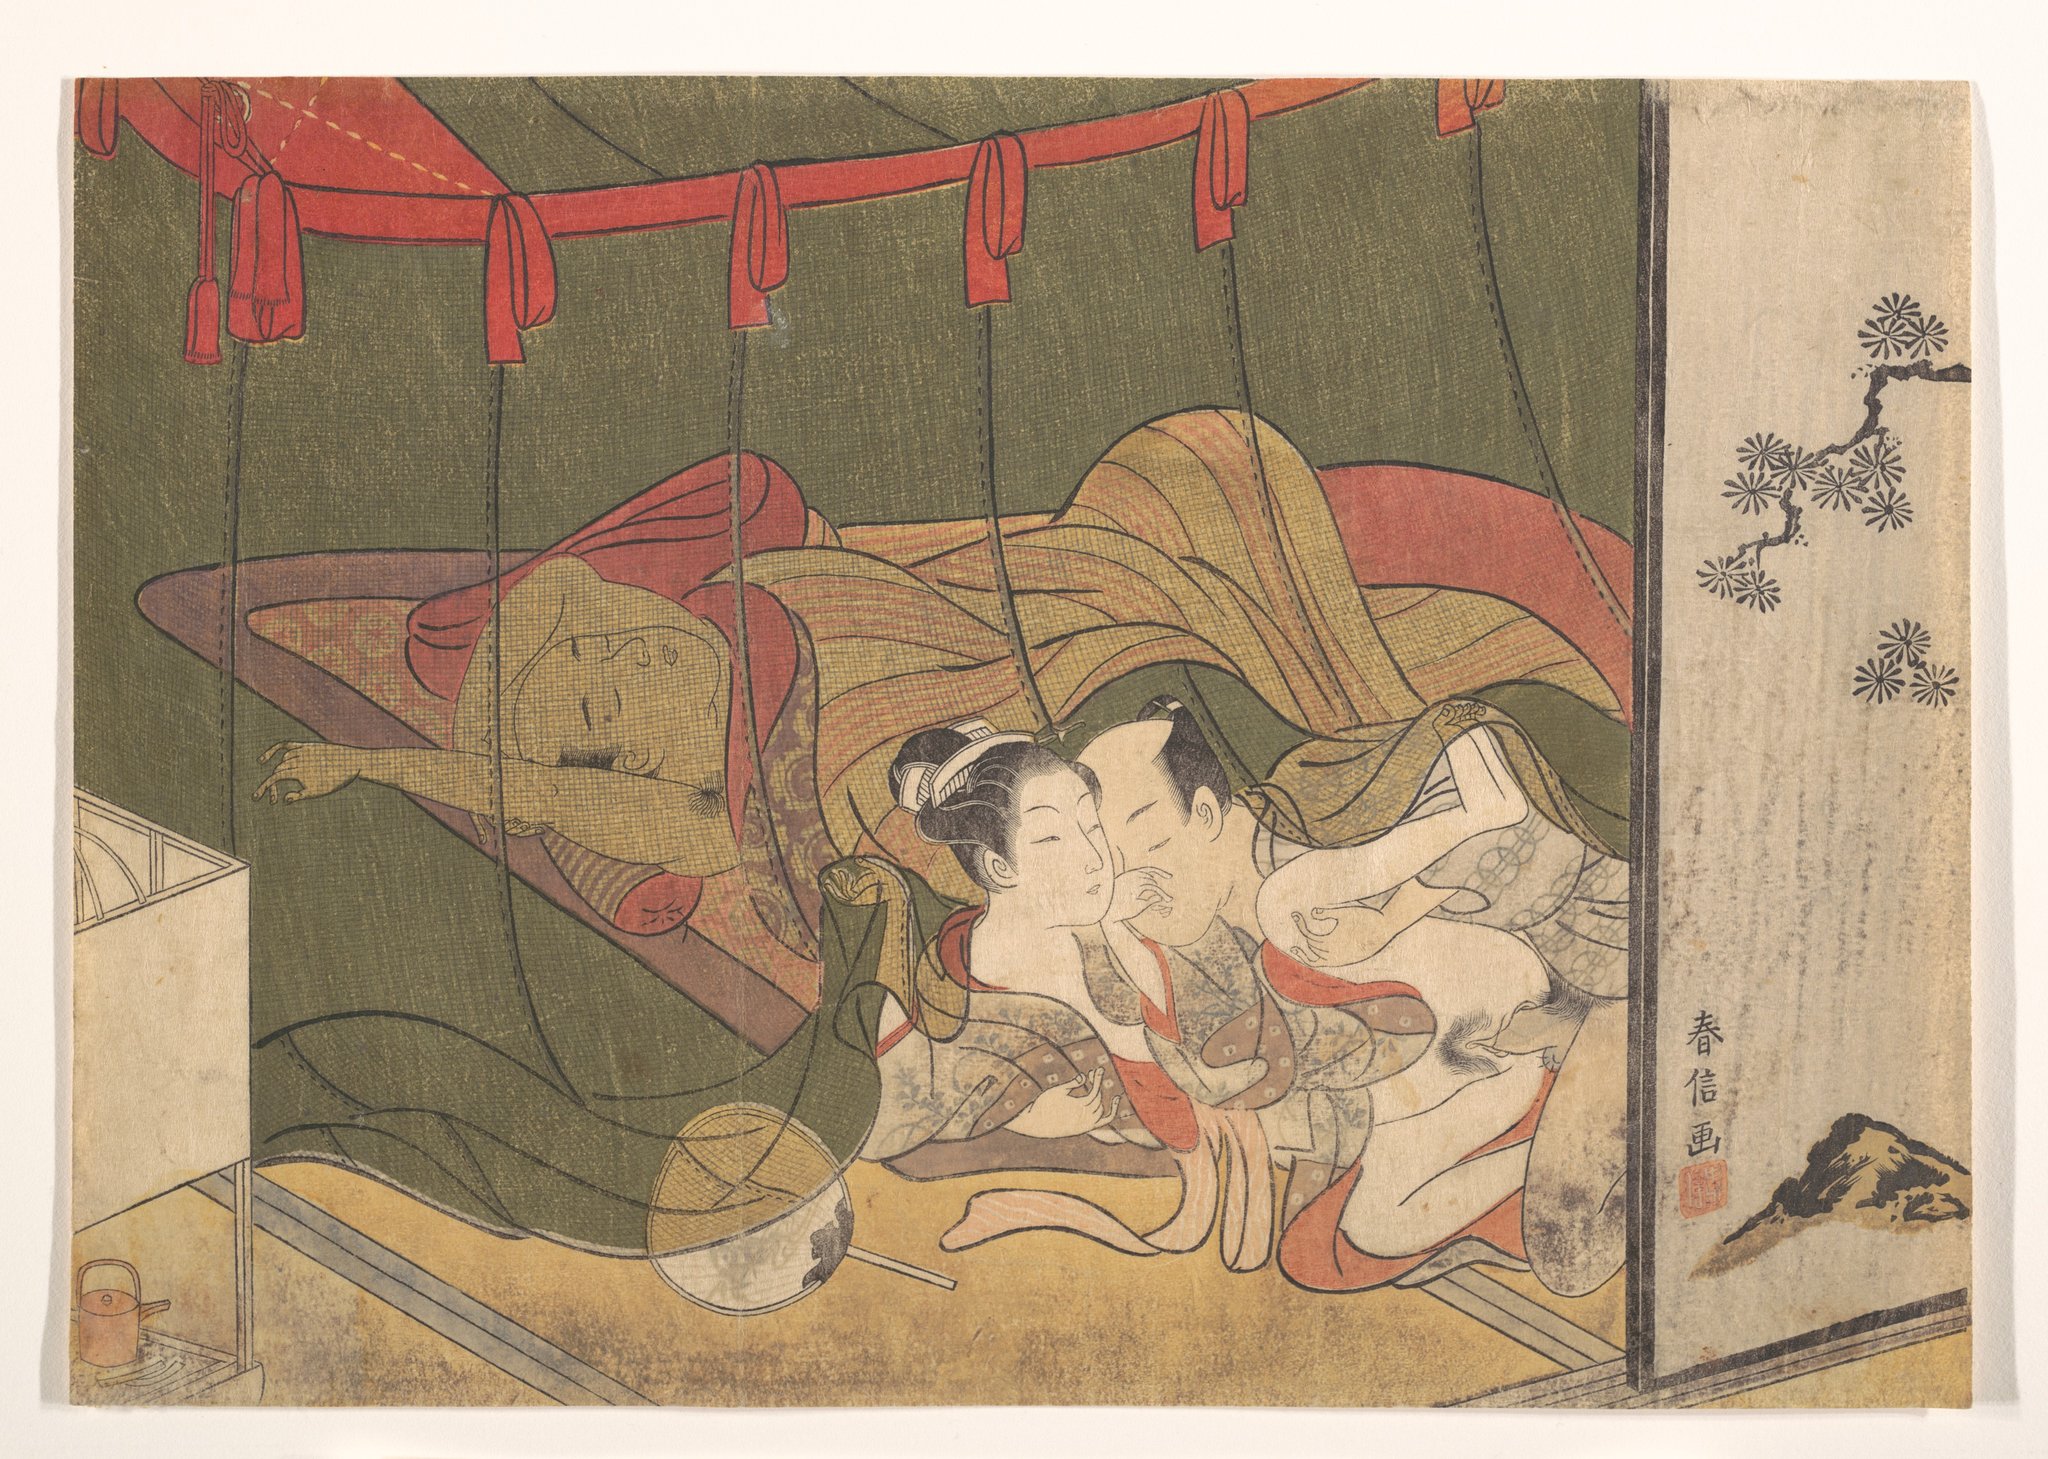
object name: print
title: Lovers Beneath a Mosquito Net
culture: japanese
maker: suzuki harunobu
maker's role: artist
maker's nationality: japanese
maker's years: 1725-1770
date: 1701-1800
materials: ink, paper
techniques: woodblock print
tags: men,lovers,women,beds